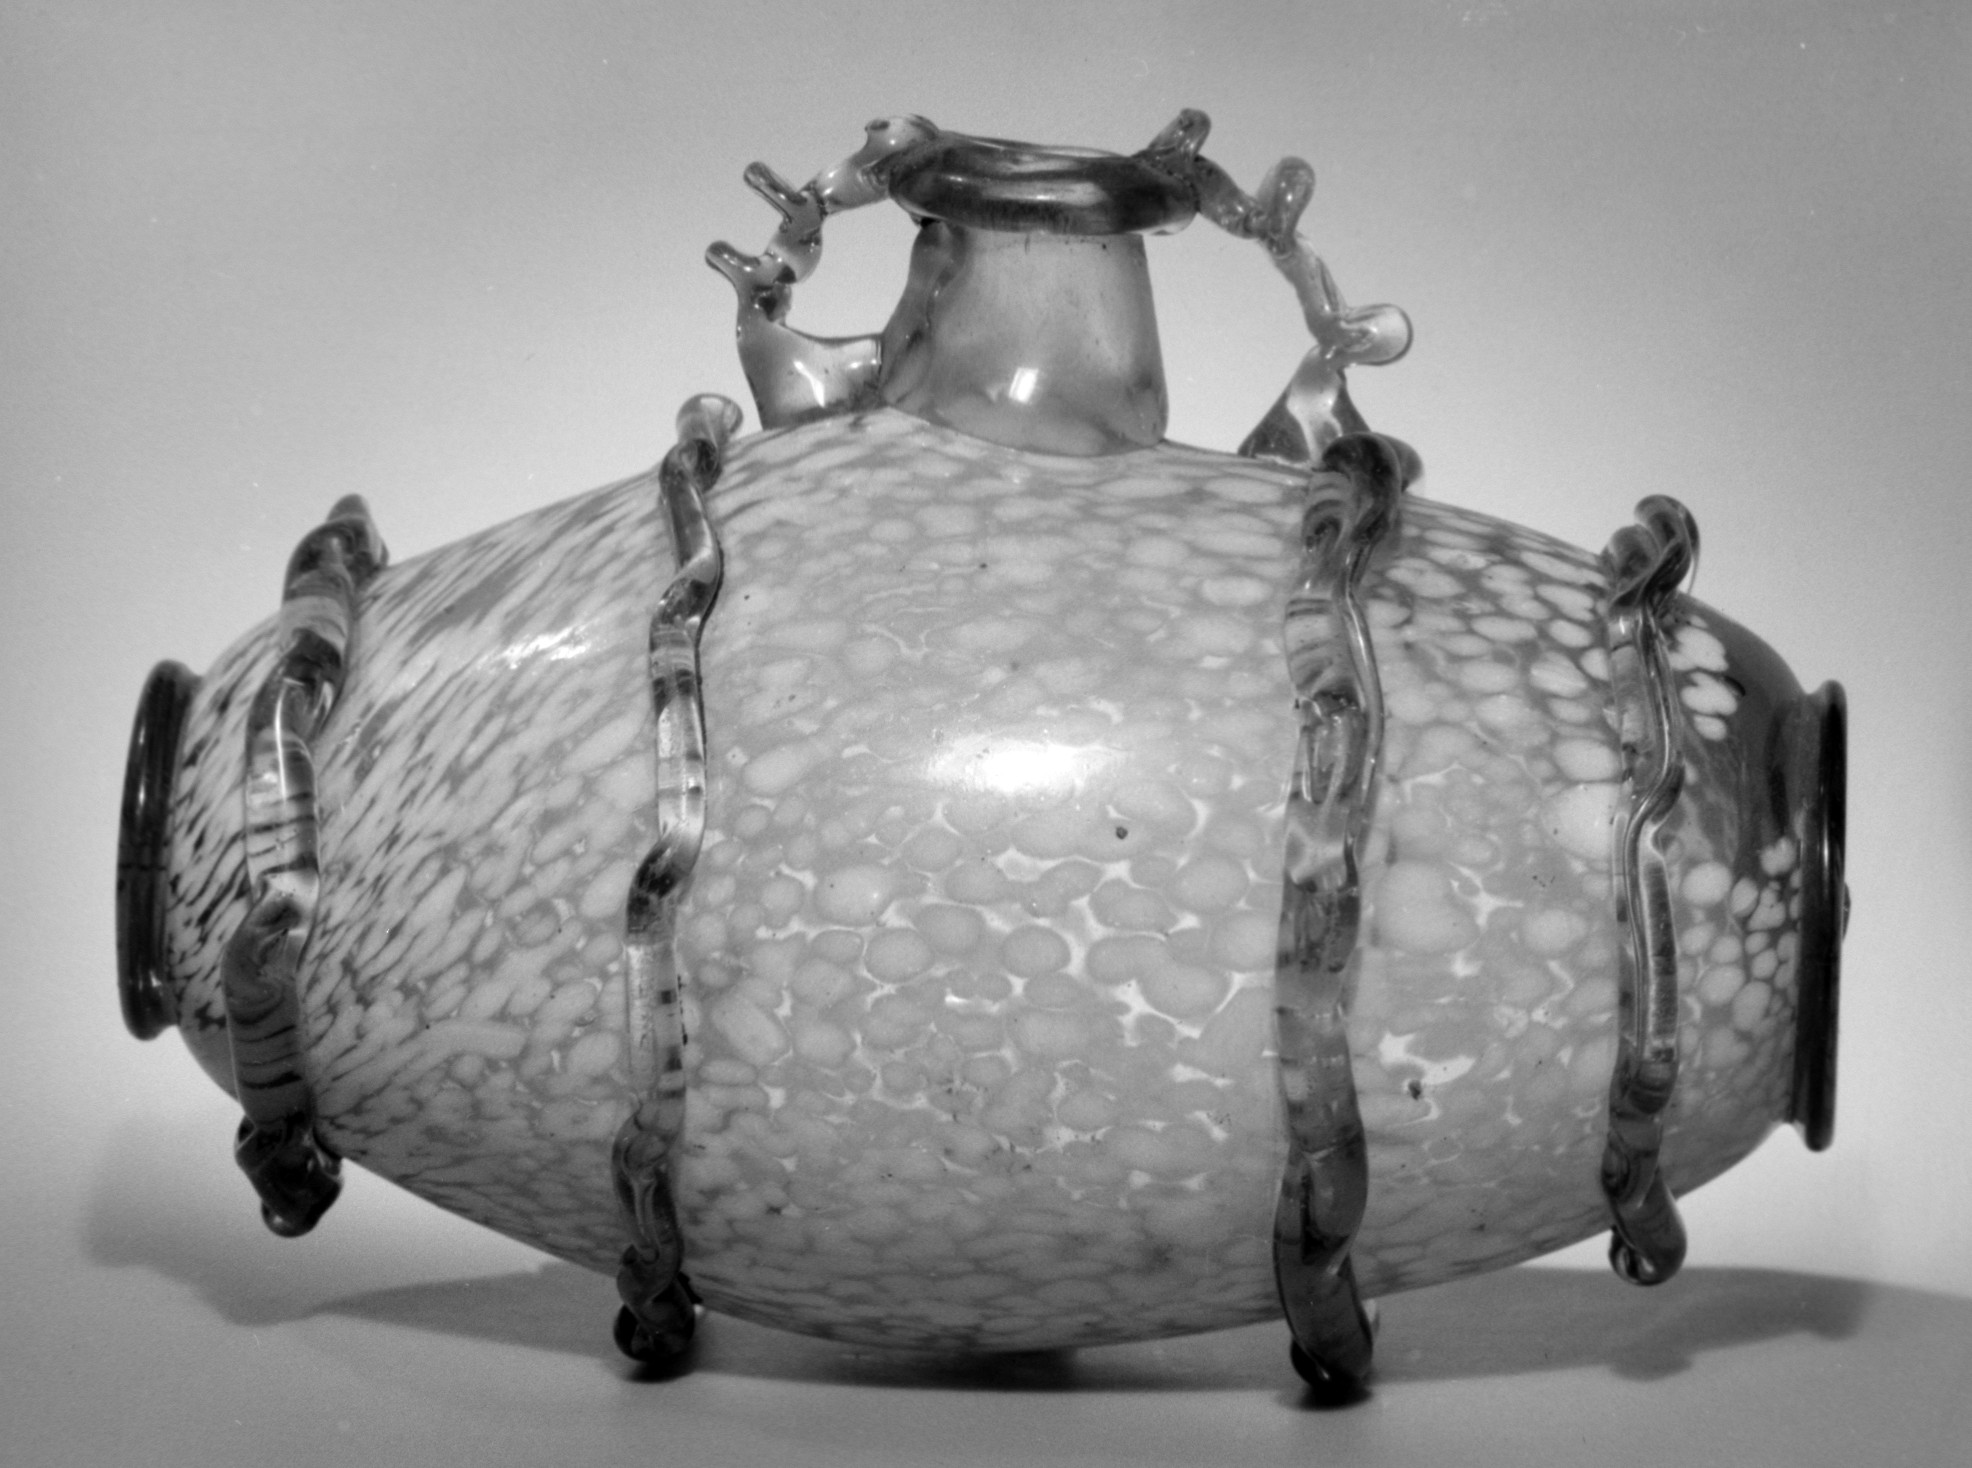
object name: flask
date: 1601-1800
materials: glass